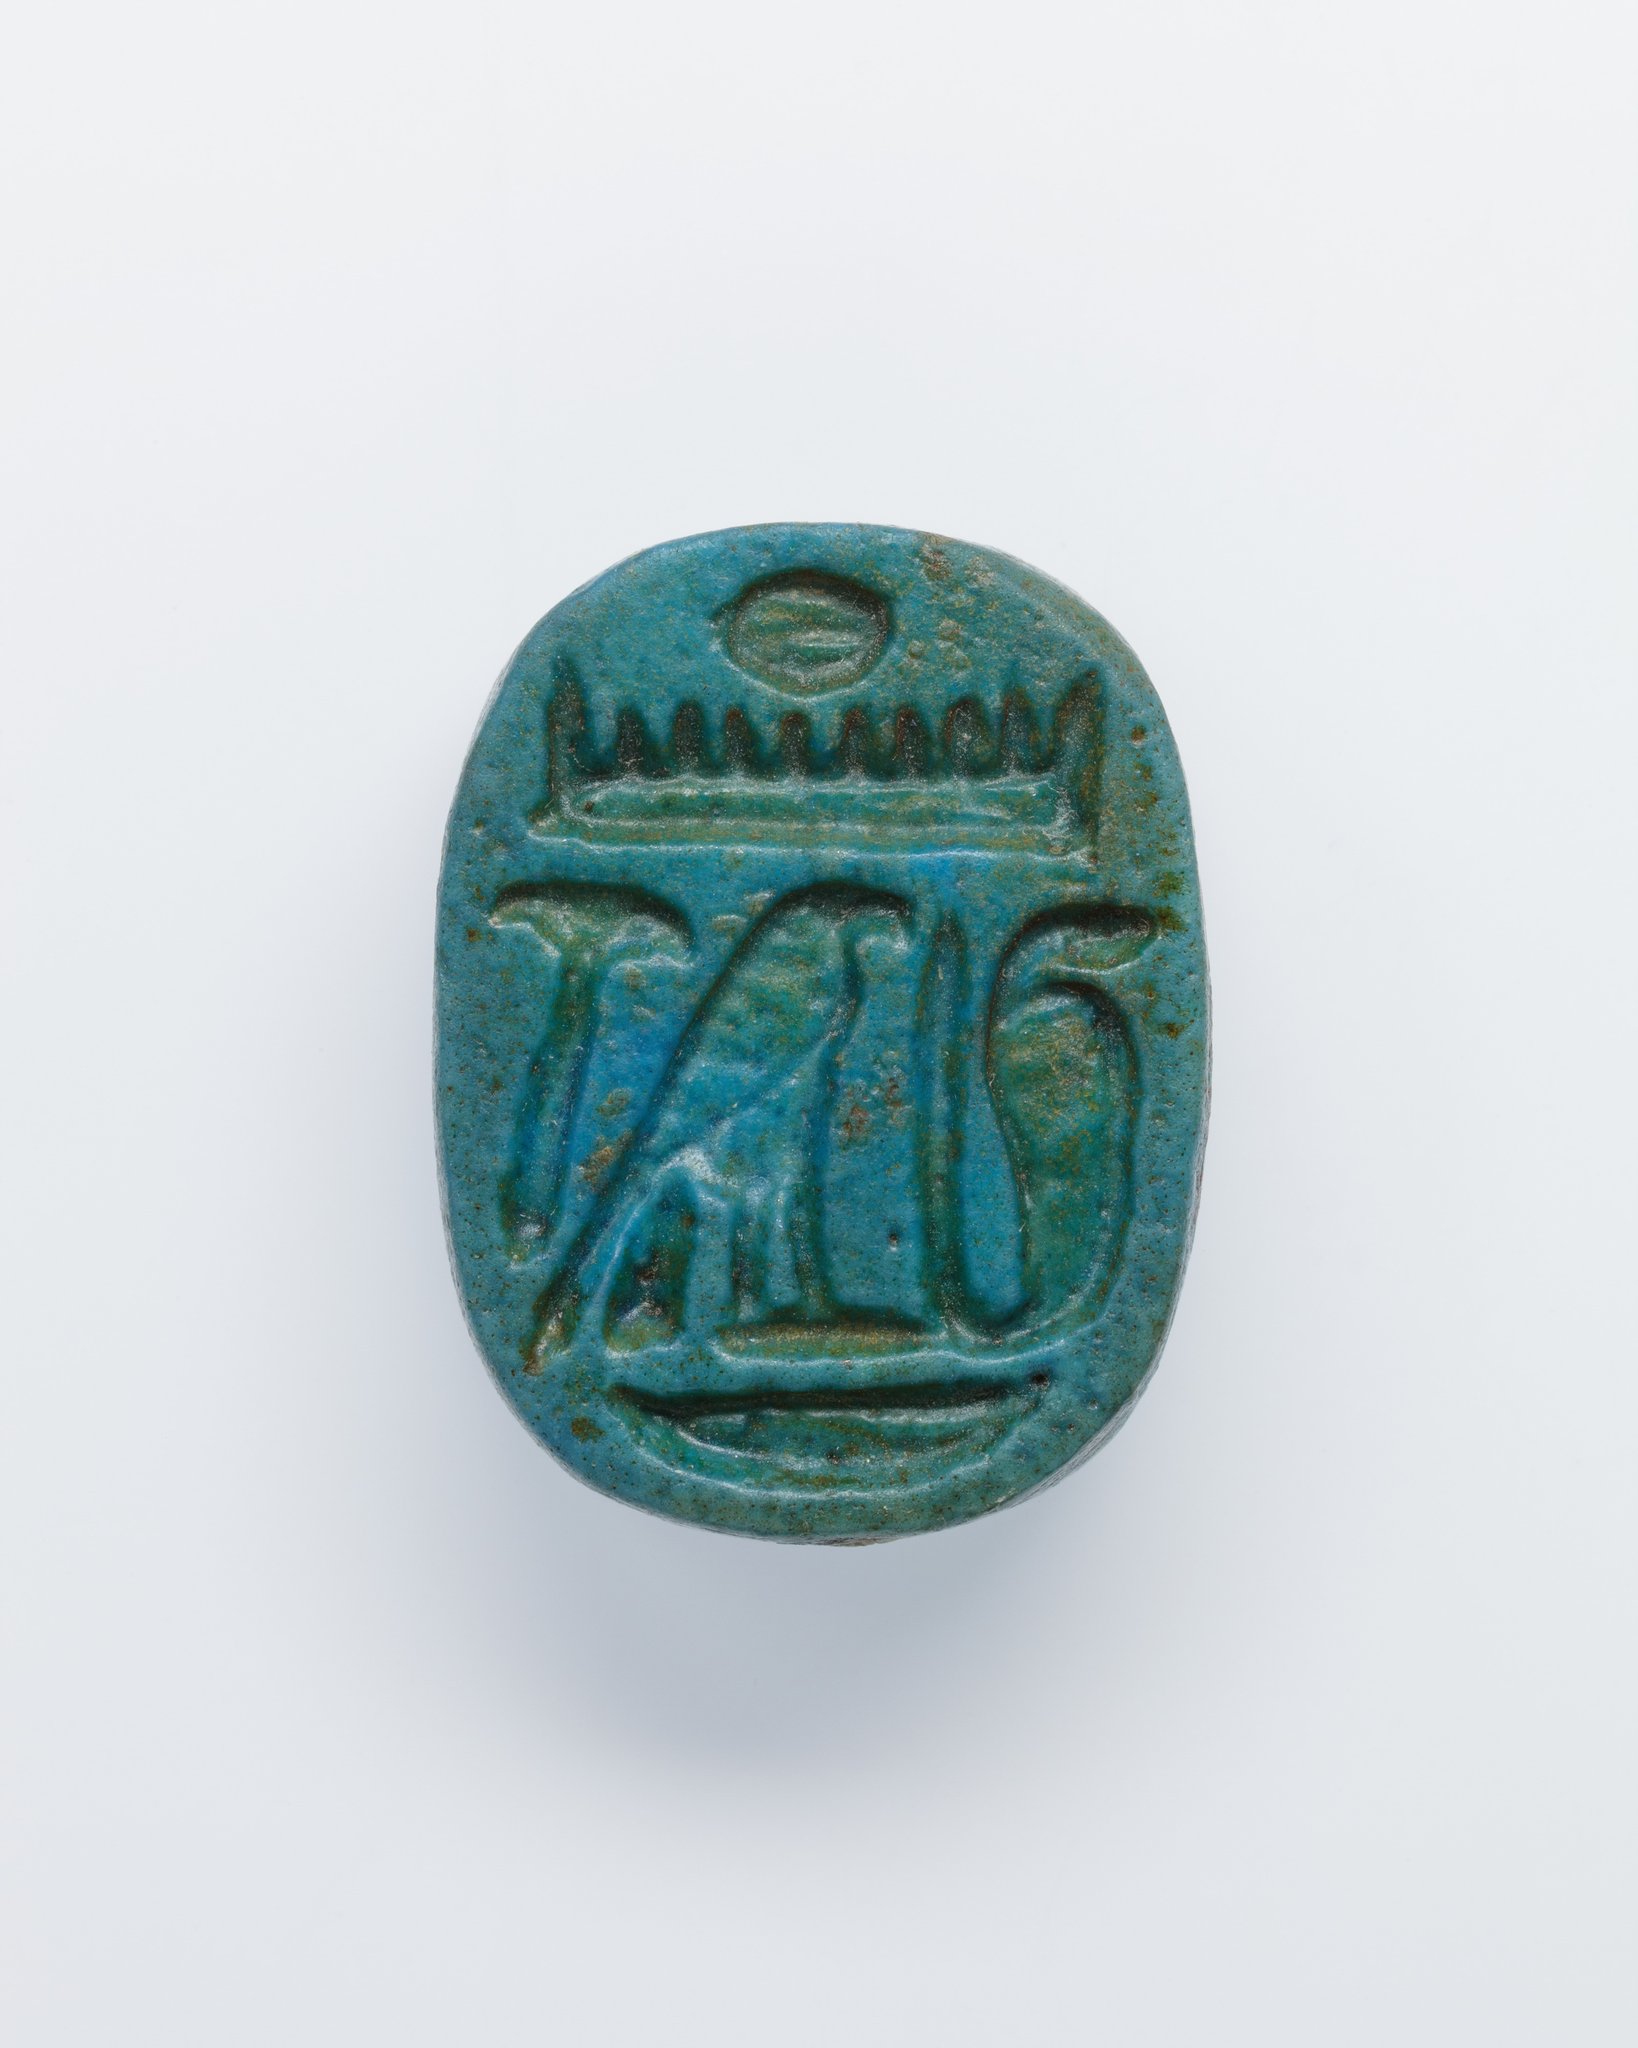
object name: bead plaque, oval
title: Bead Plaque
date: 733-664 BCE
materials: faience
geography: egypt